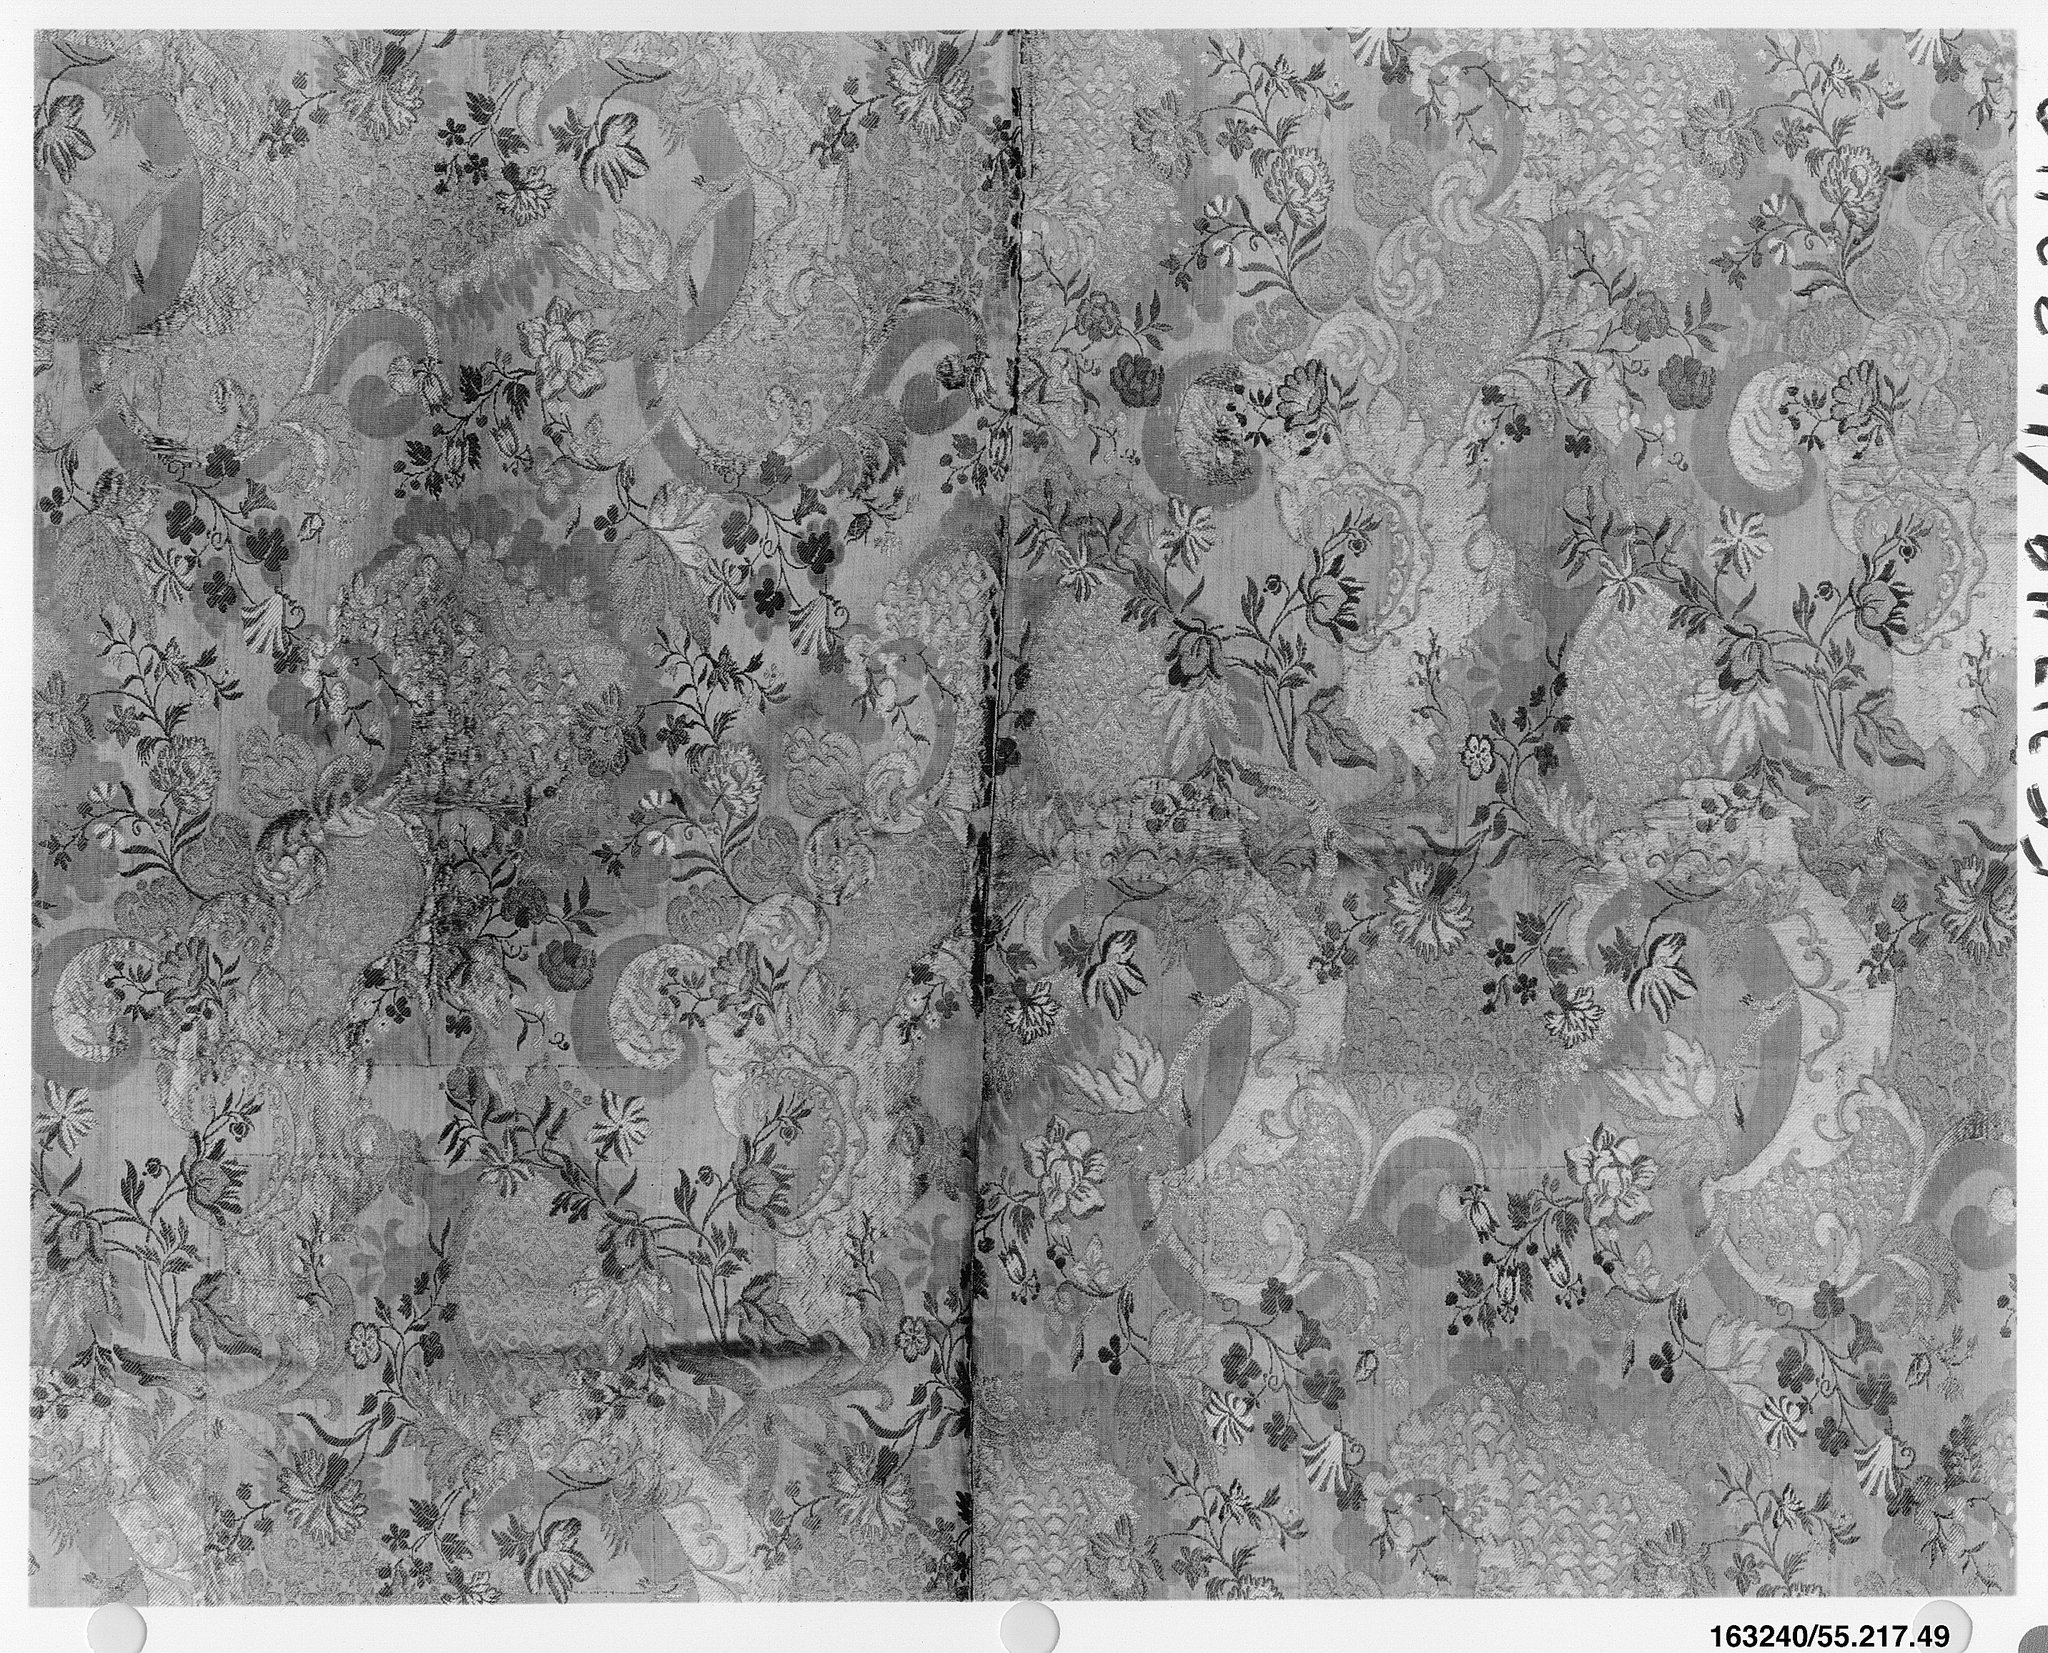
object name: piece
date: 1715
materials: metal thread, silk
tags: flowers,leaves